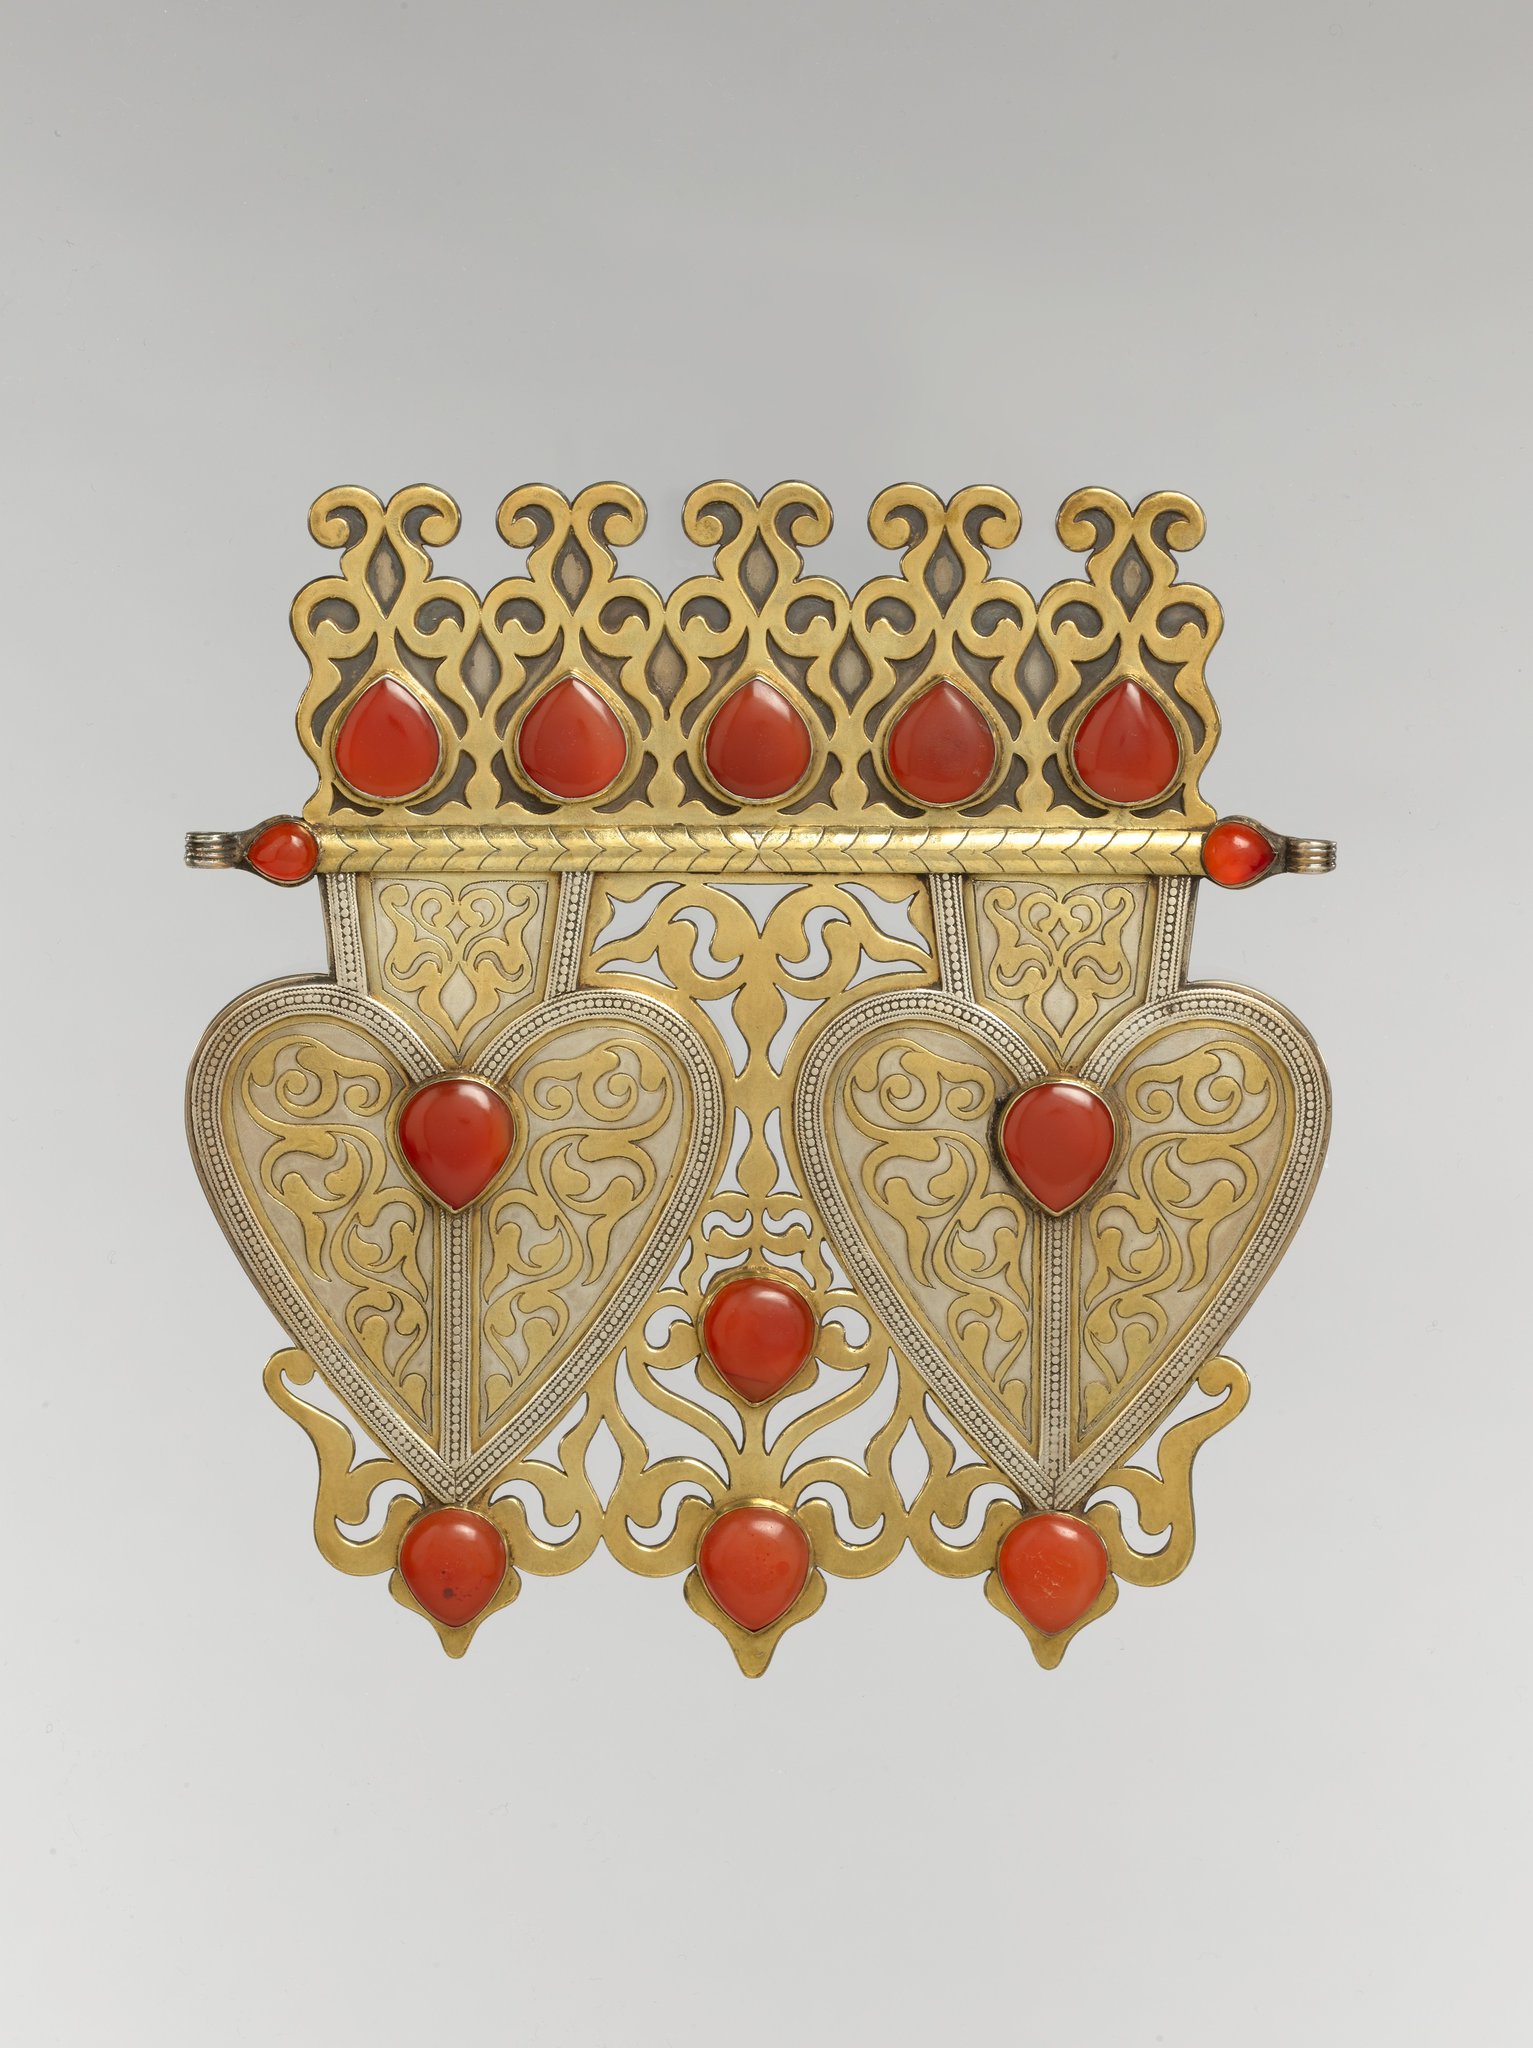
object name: ornament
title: Double Cordiform Pendant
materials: carnelian, silver, metal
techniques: chasing, gilding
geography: central asia